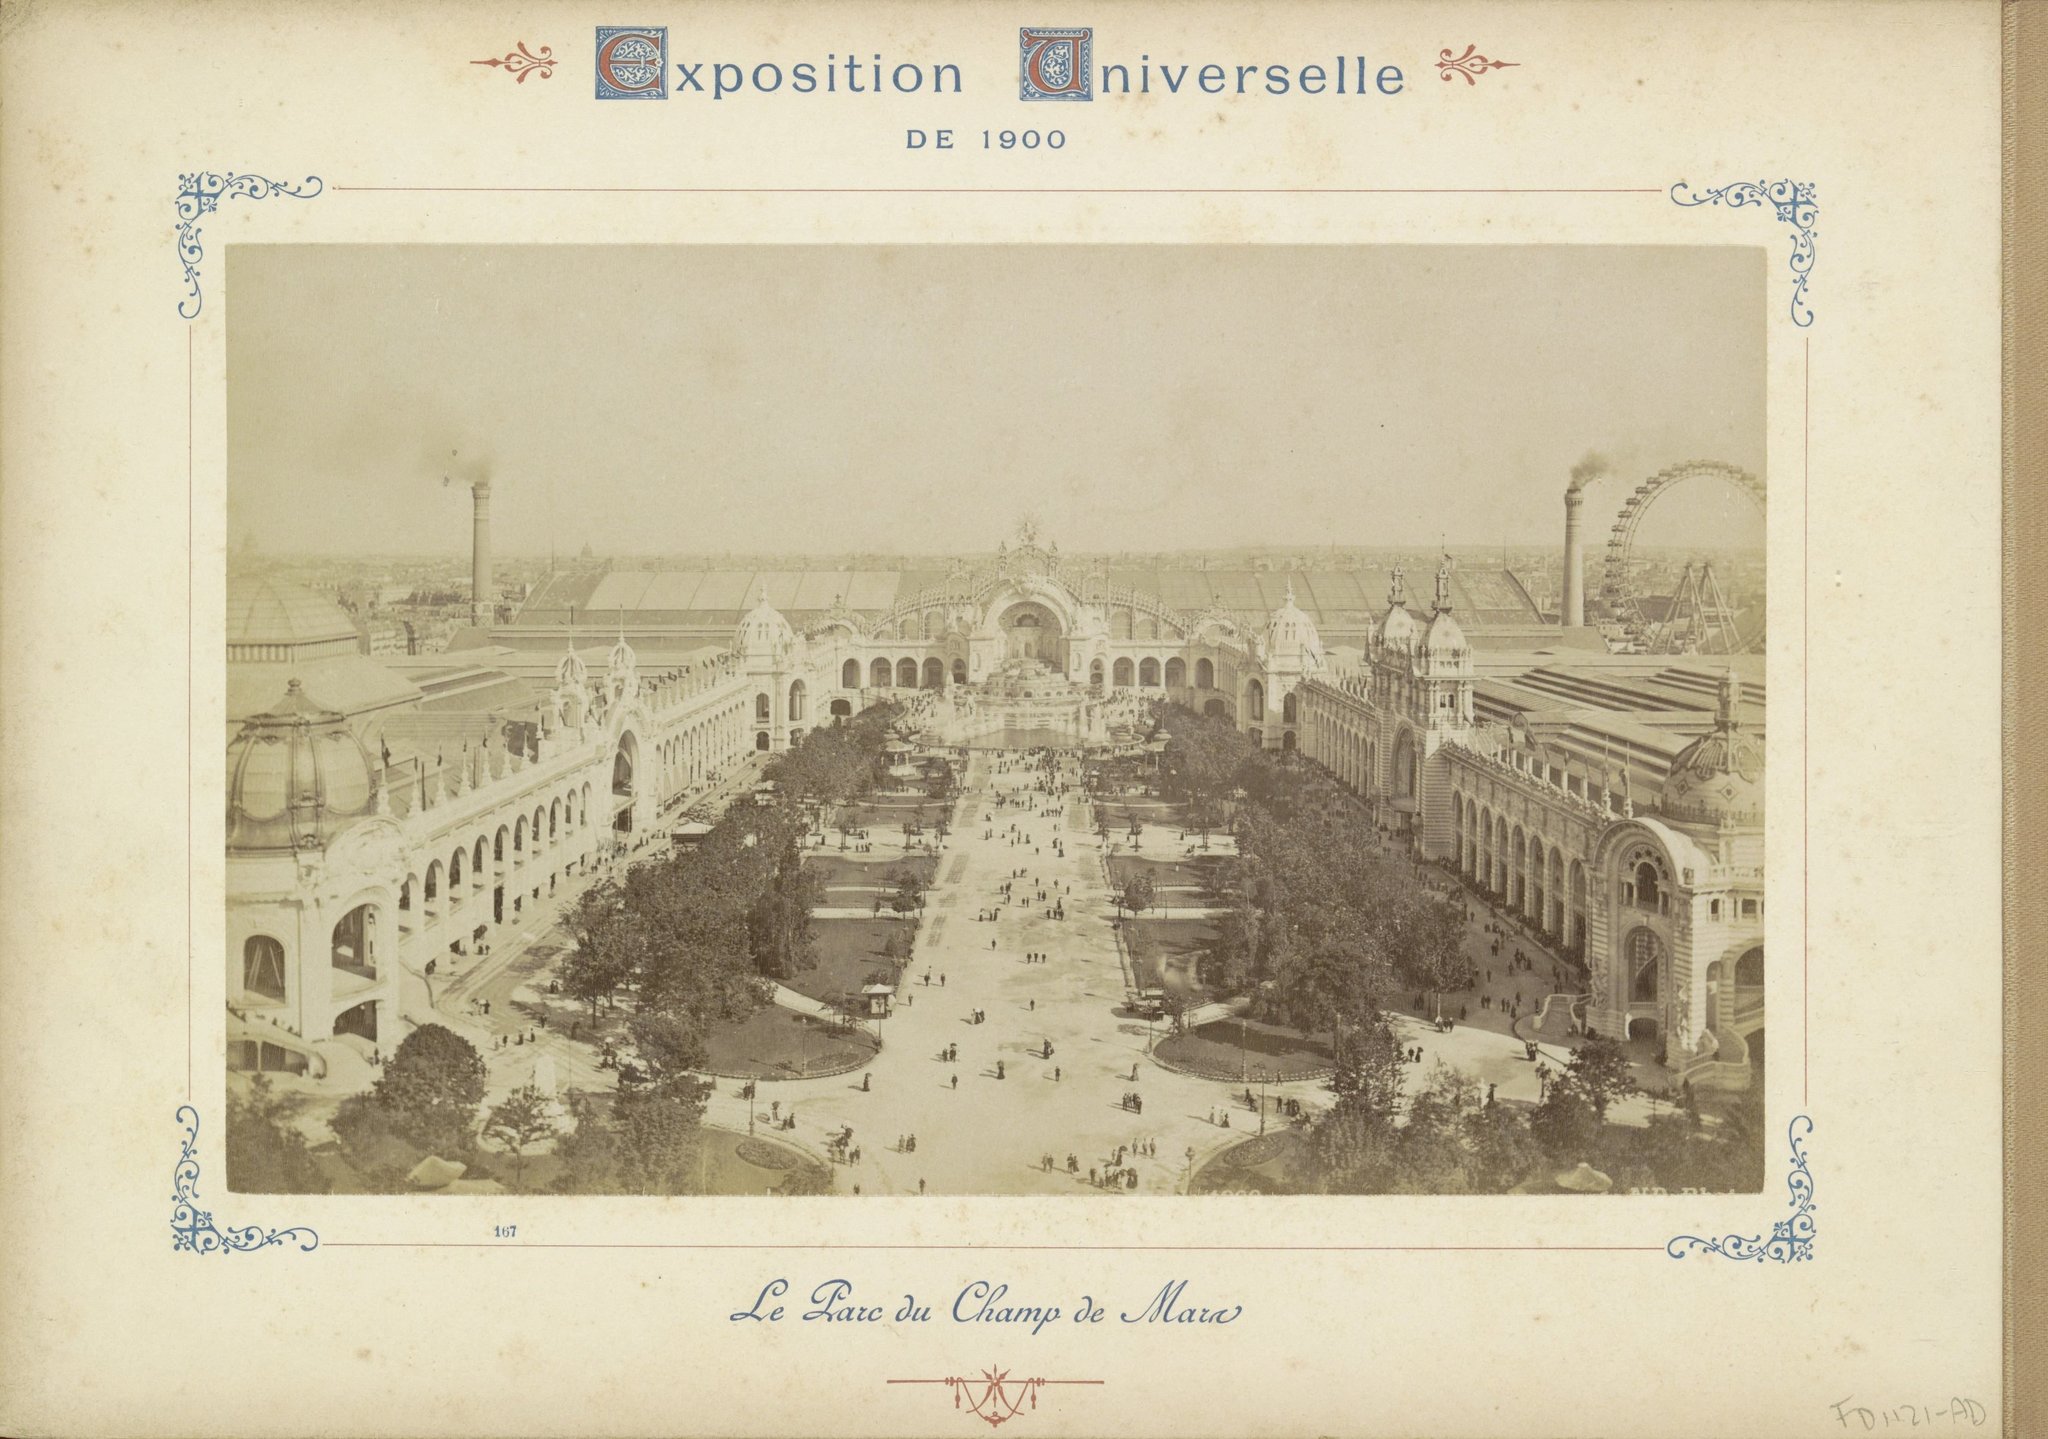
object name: photograph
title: Le Parc du Champ de Mars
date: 1900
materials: cardboard, paper, photographic support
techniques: albumen print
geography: paris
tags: public gardens, park (+ city(-scape) with figures, staffage), world fair, world exhibition, palace, ornamental fountain (+ city(-scape) with figures, staffage), prospect of city, town panorama, silhouette of city, paris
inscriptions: number: ‘167’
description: Onderdeel van Fotoalbum met opnames van de Wereldtentoonstelling van 1900 in Parijs.